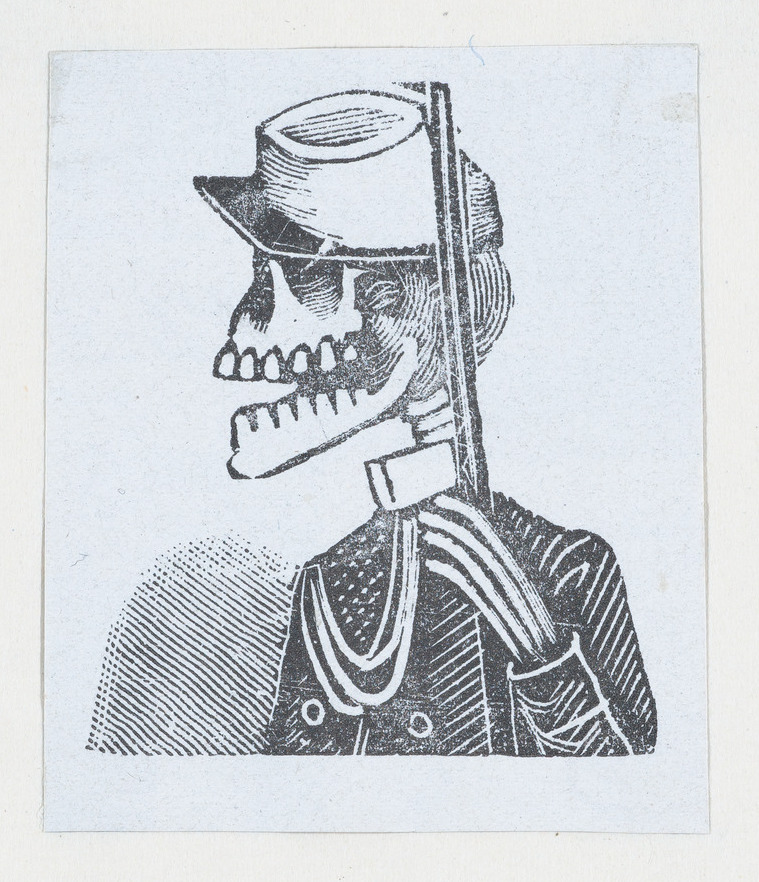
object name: print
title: Male skeleton wearing military dress (vignette for the feast of the dead)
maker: josé guadalupe posada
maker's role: artist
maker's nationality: mexican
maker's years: 1852-1913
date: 1892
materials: metal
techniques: engraving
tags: skeletons